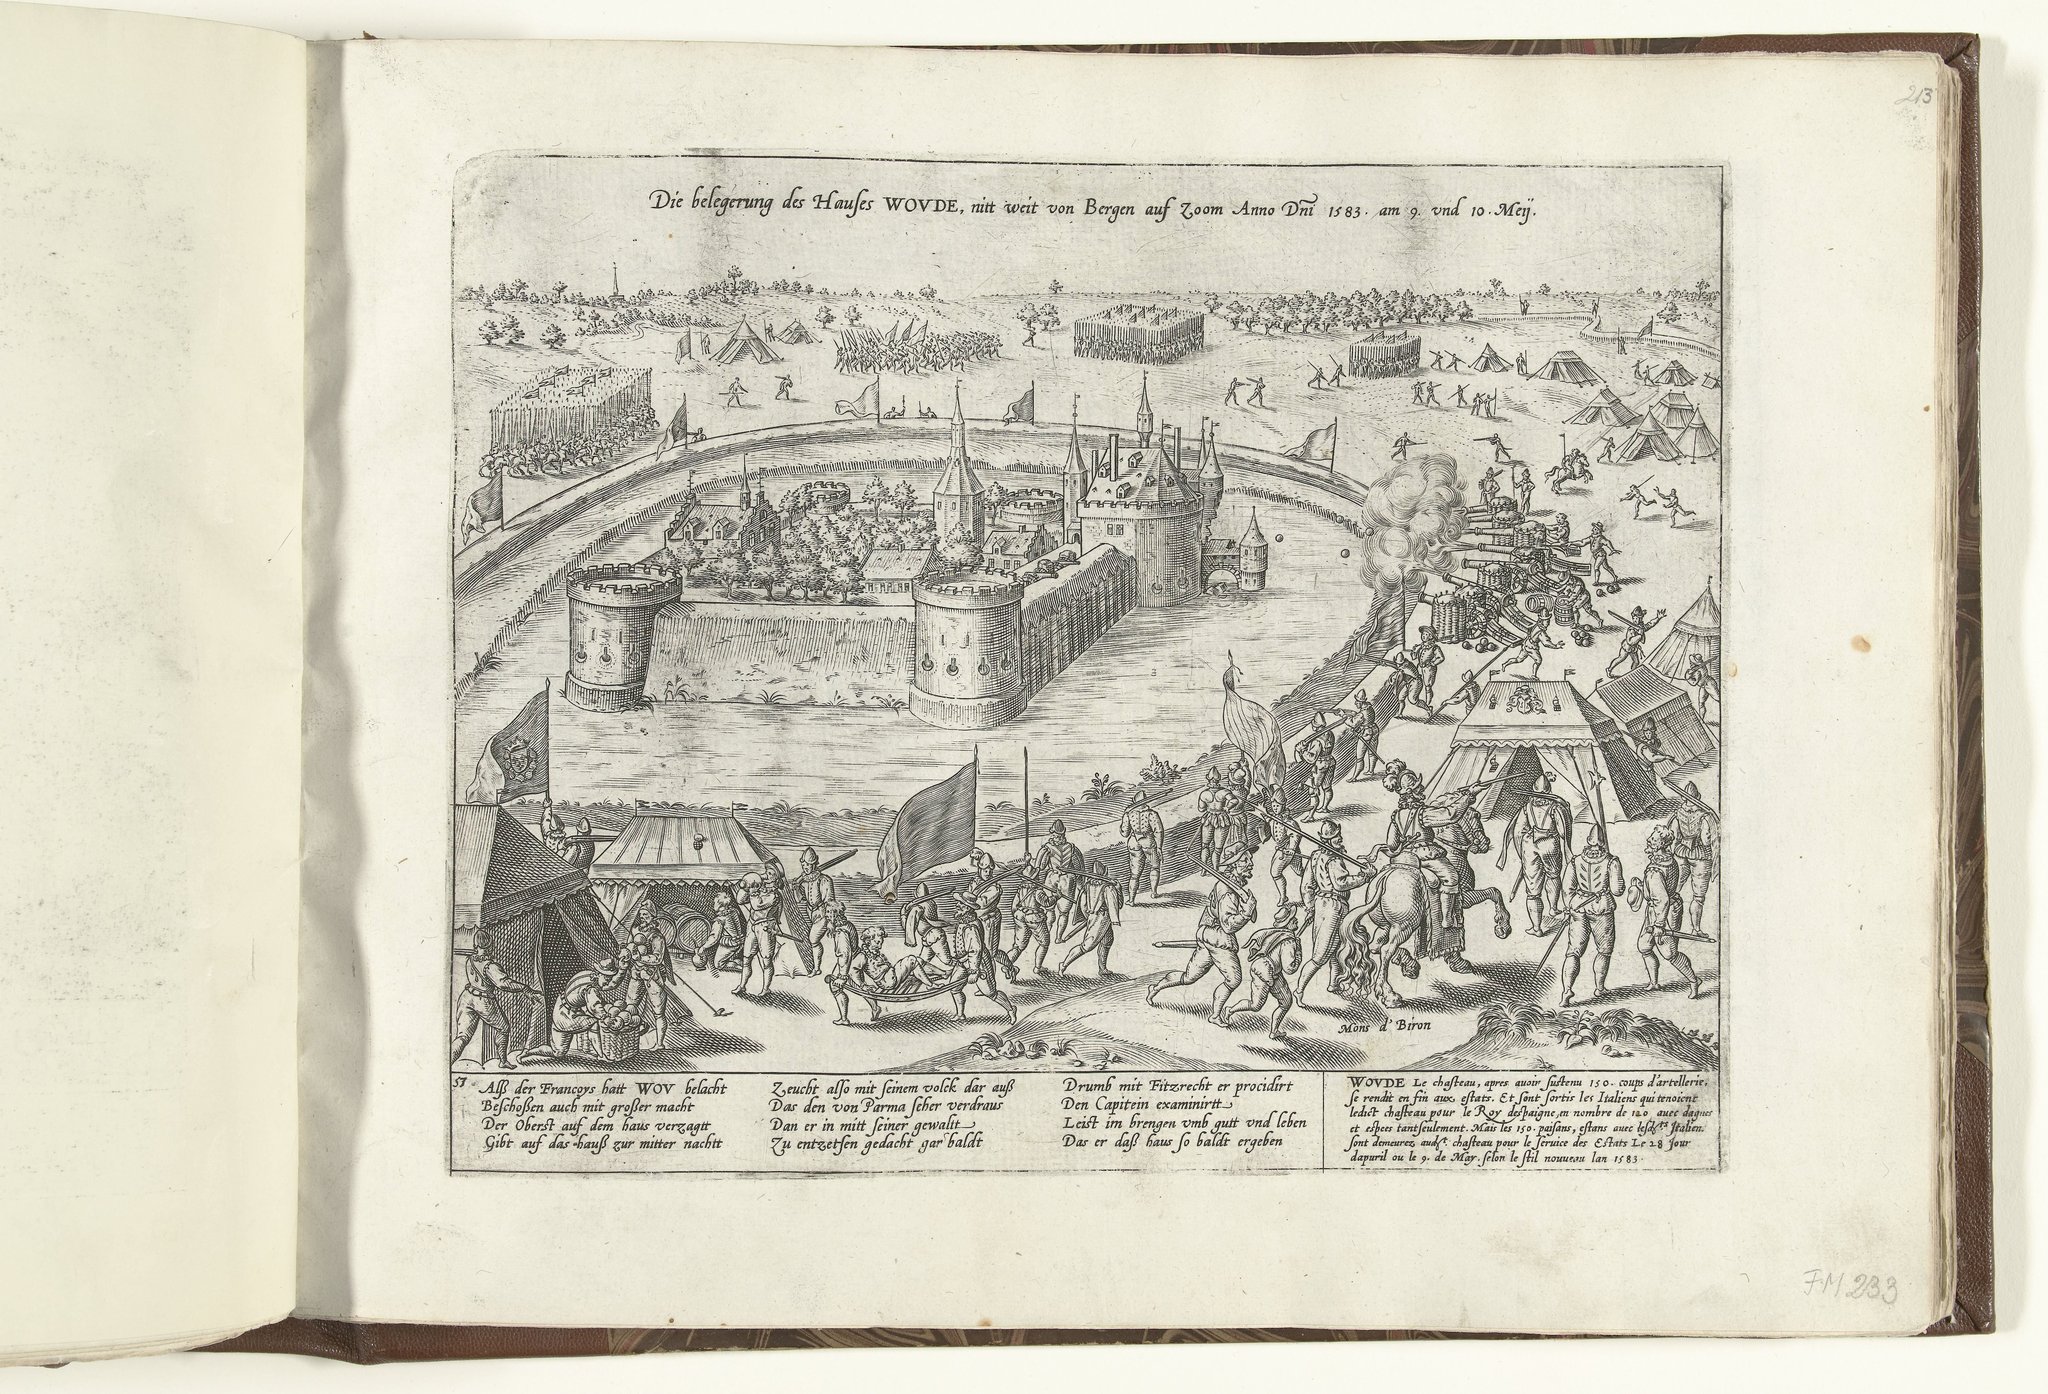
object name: print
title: Beleg van het kasteel van Wouw bij Bergen op Zoom, 1583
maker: frans hogenberg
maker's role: print maker, publisher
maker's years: 1538-1590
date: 1583-1585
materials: paper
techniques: engraving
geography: cologne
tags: politician, siege, position war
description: Beleg en verovering van het kasteel van Wouw bij Bergen op Zoom door het Staatse leger onder maarschalk Biron, 9 - 10 mei 1583. Met onderschrift van 12 regels in het Duits en 6 regels in het Frans. Genummerd: 57.